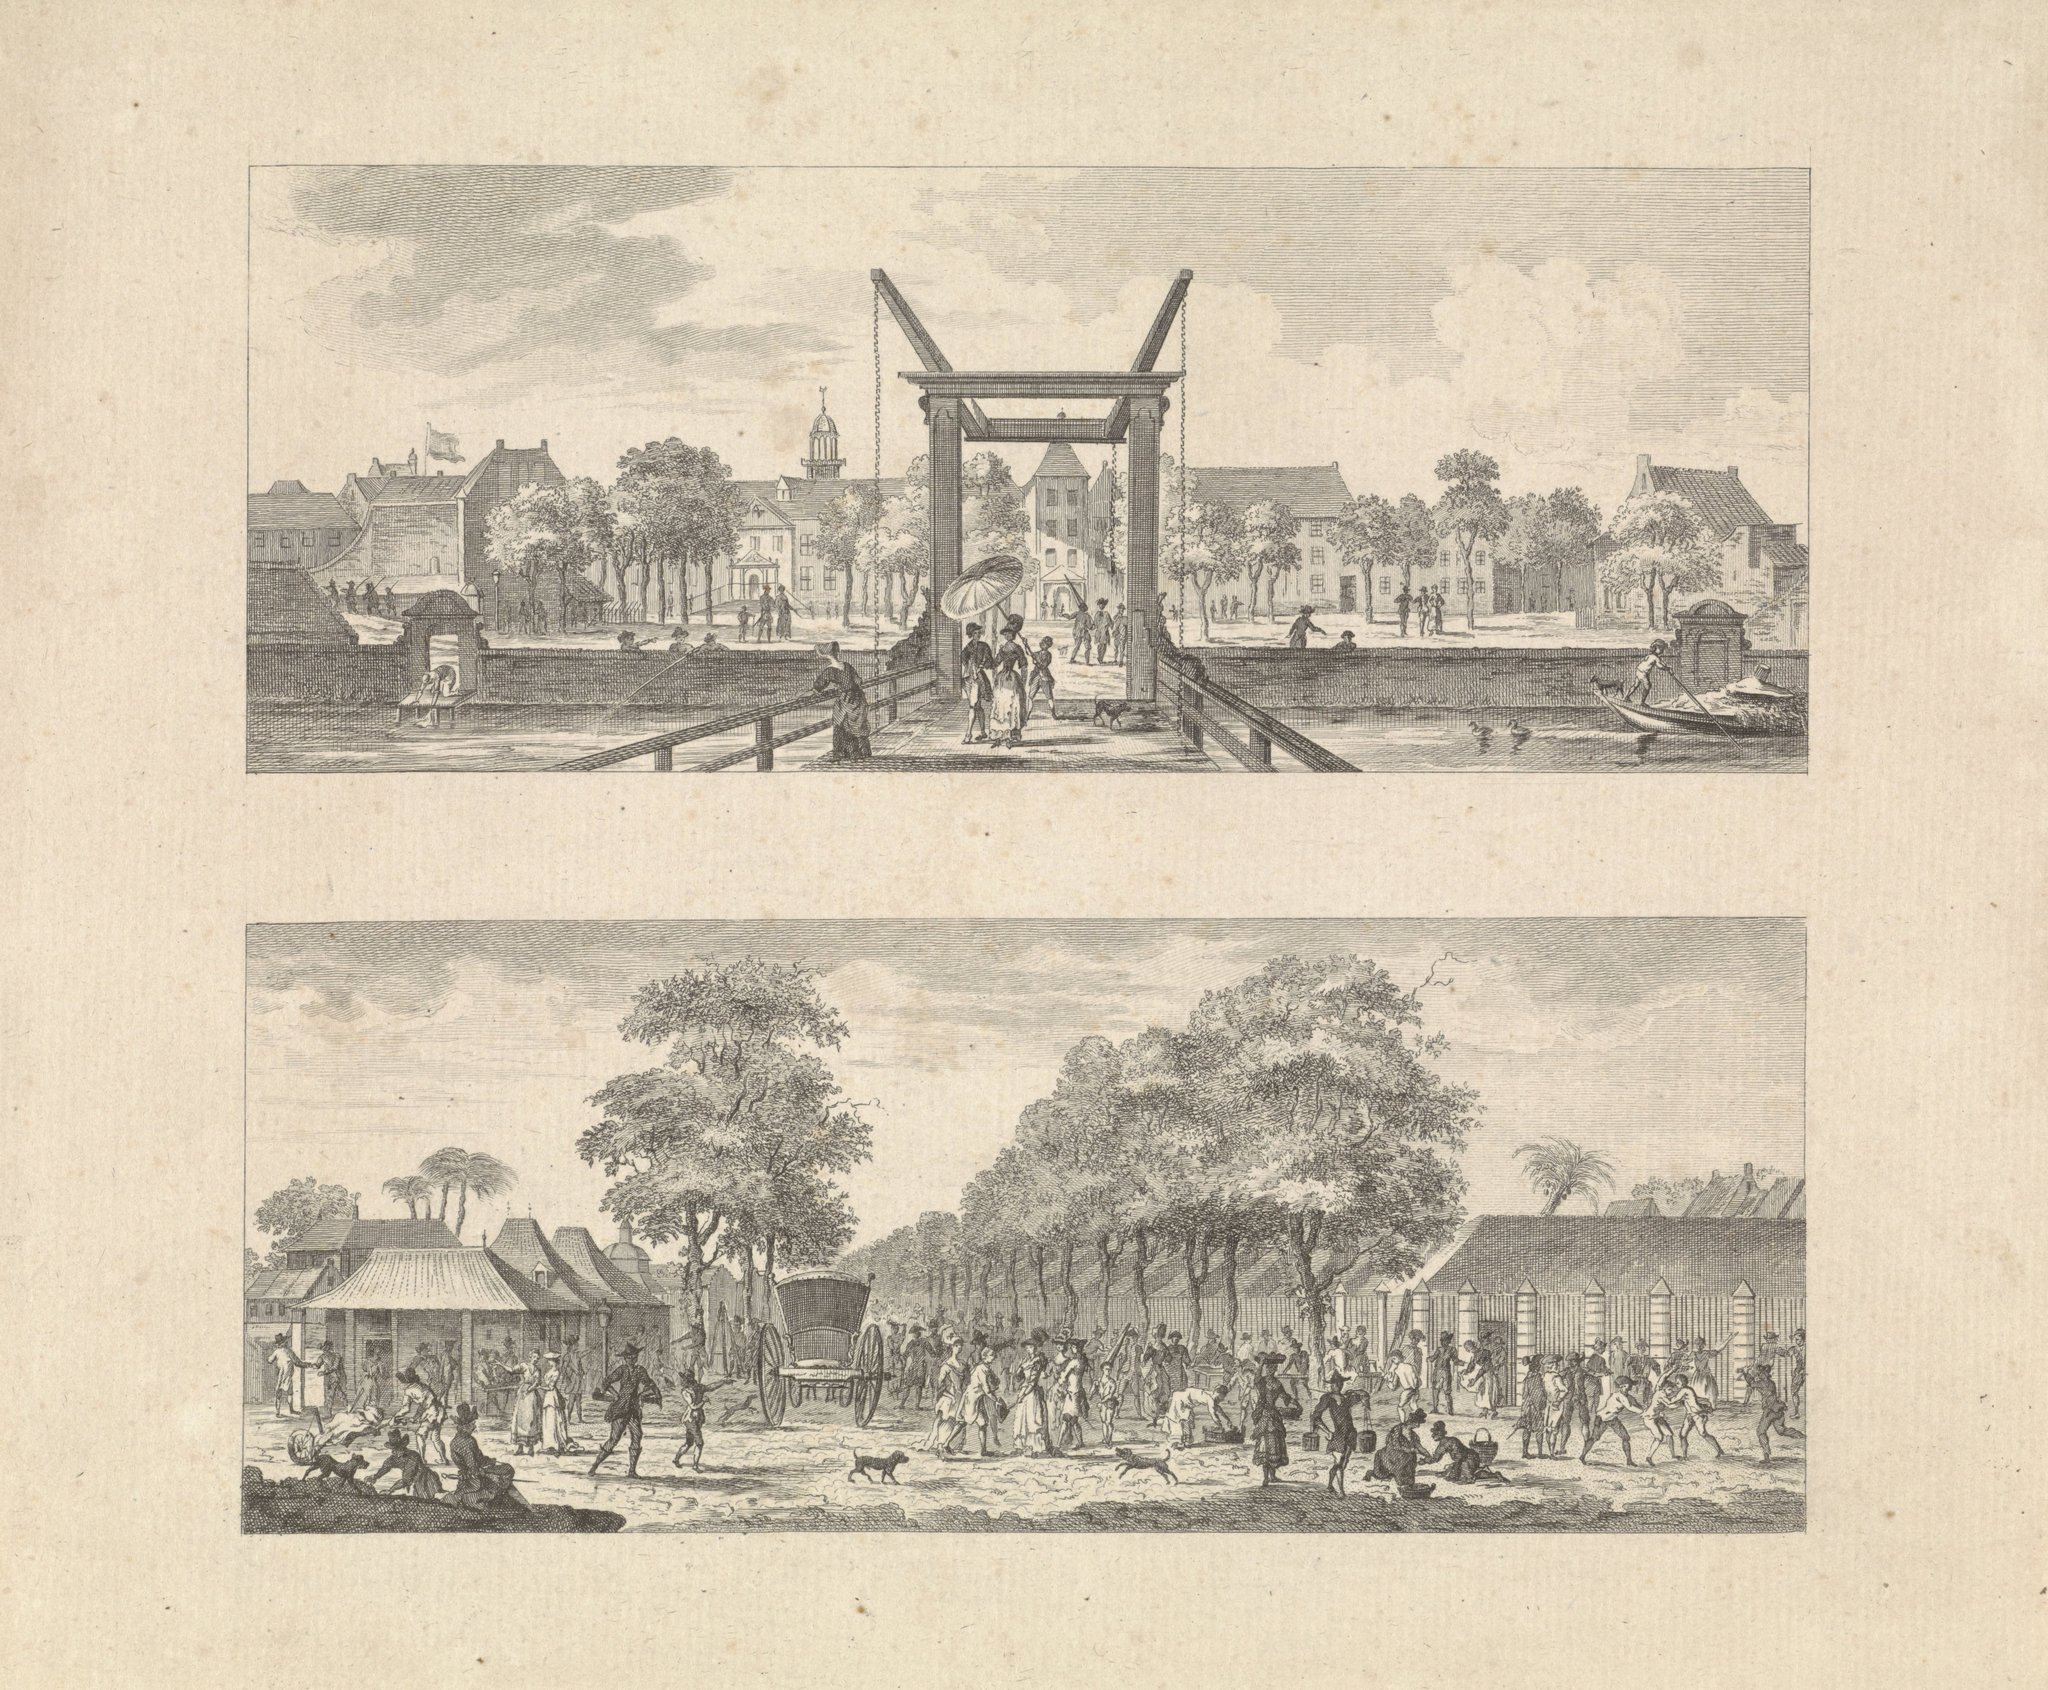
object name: print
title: Gezichten op het gouvernementsgebouw en de markt van Batavia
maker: mathias de sallieth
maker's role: print maker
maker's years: 1749-1791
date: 1779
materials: paper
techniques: etching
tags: governmental and representative bodies, landscapes in the non-temperate zone, exotic landscapes, market, batavia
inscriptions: collector's mark: Lugt 2228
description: Twee voorstellingen van een plaat met gezichten op het gouvernementsgebouw (boven) en de markt van Batavia (onder).